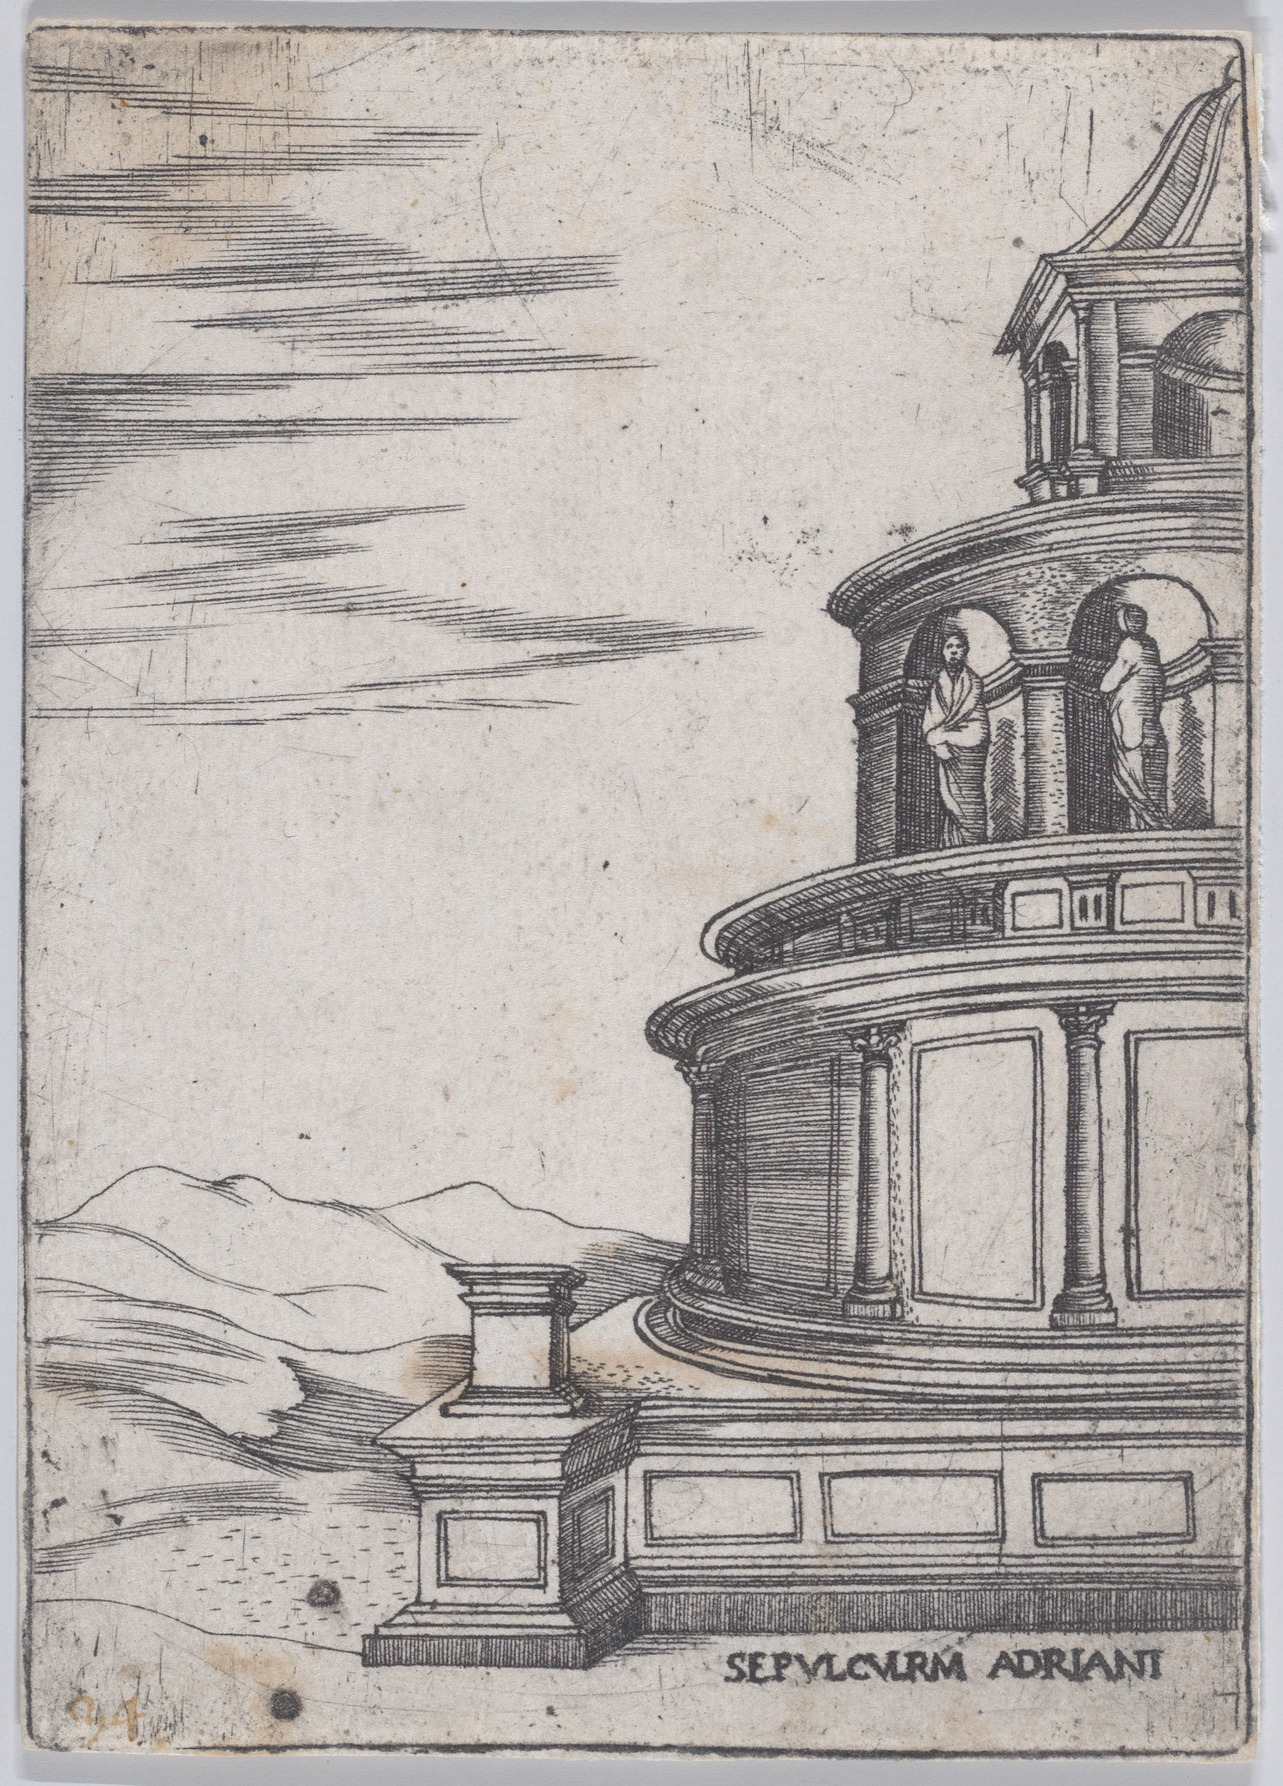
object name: print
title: Sepulchrum Adriani, from "Views of Ancient Roman Temples and Arches"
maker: anonymous, italian, 16th century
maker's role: artist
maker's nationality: italian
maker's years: 1500-1600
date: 1535-1540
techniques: engraving